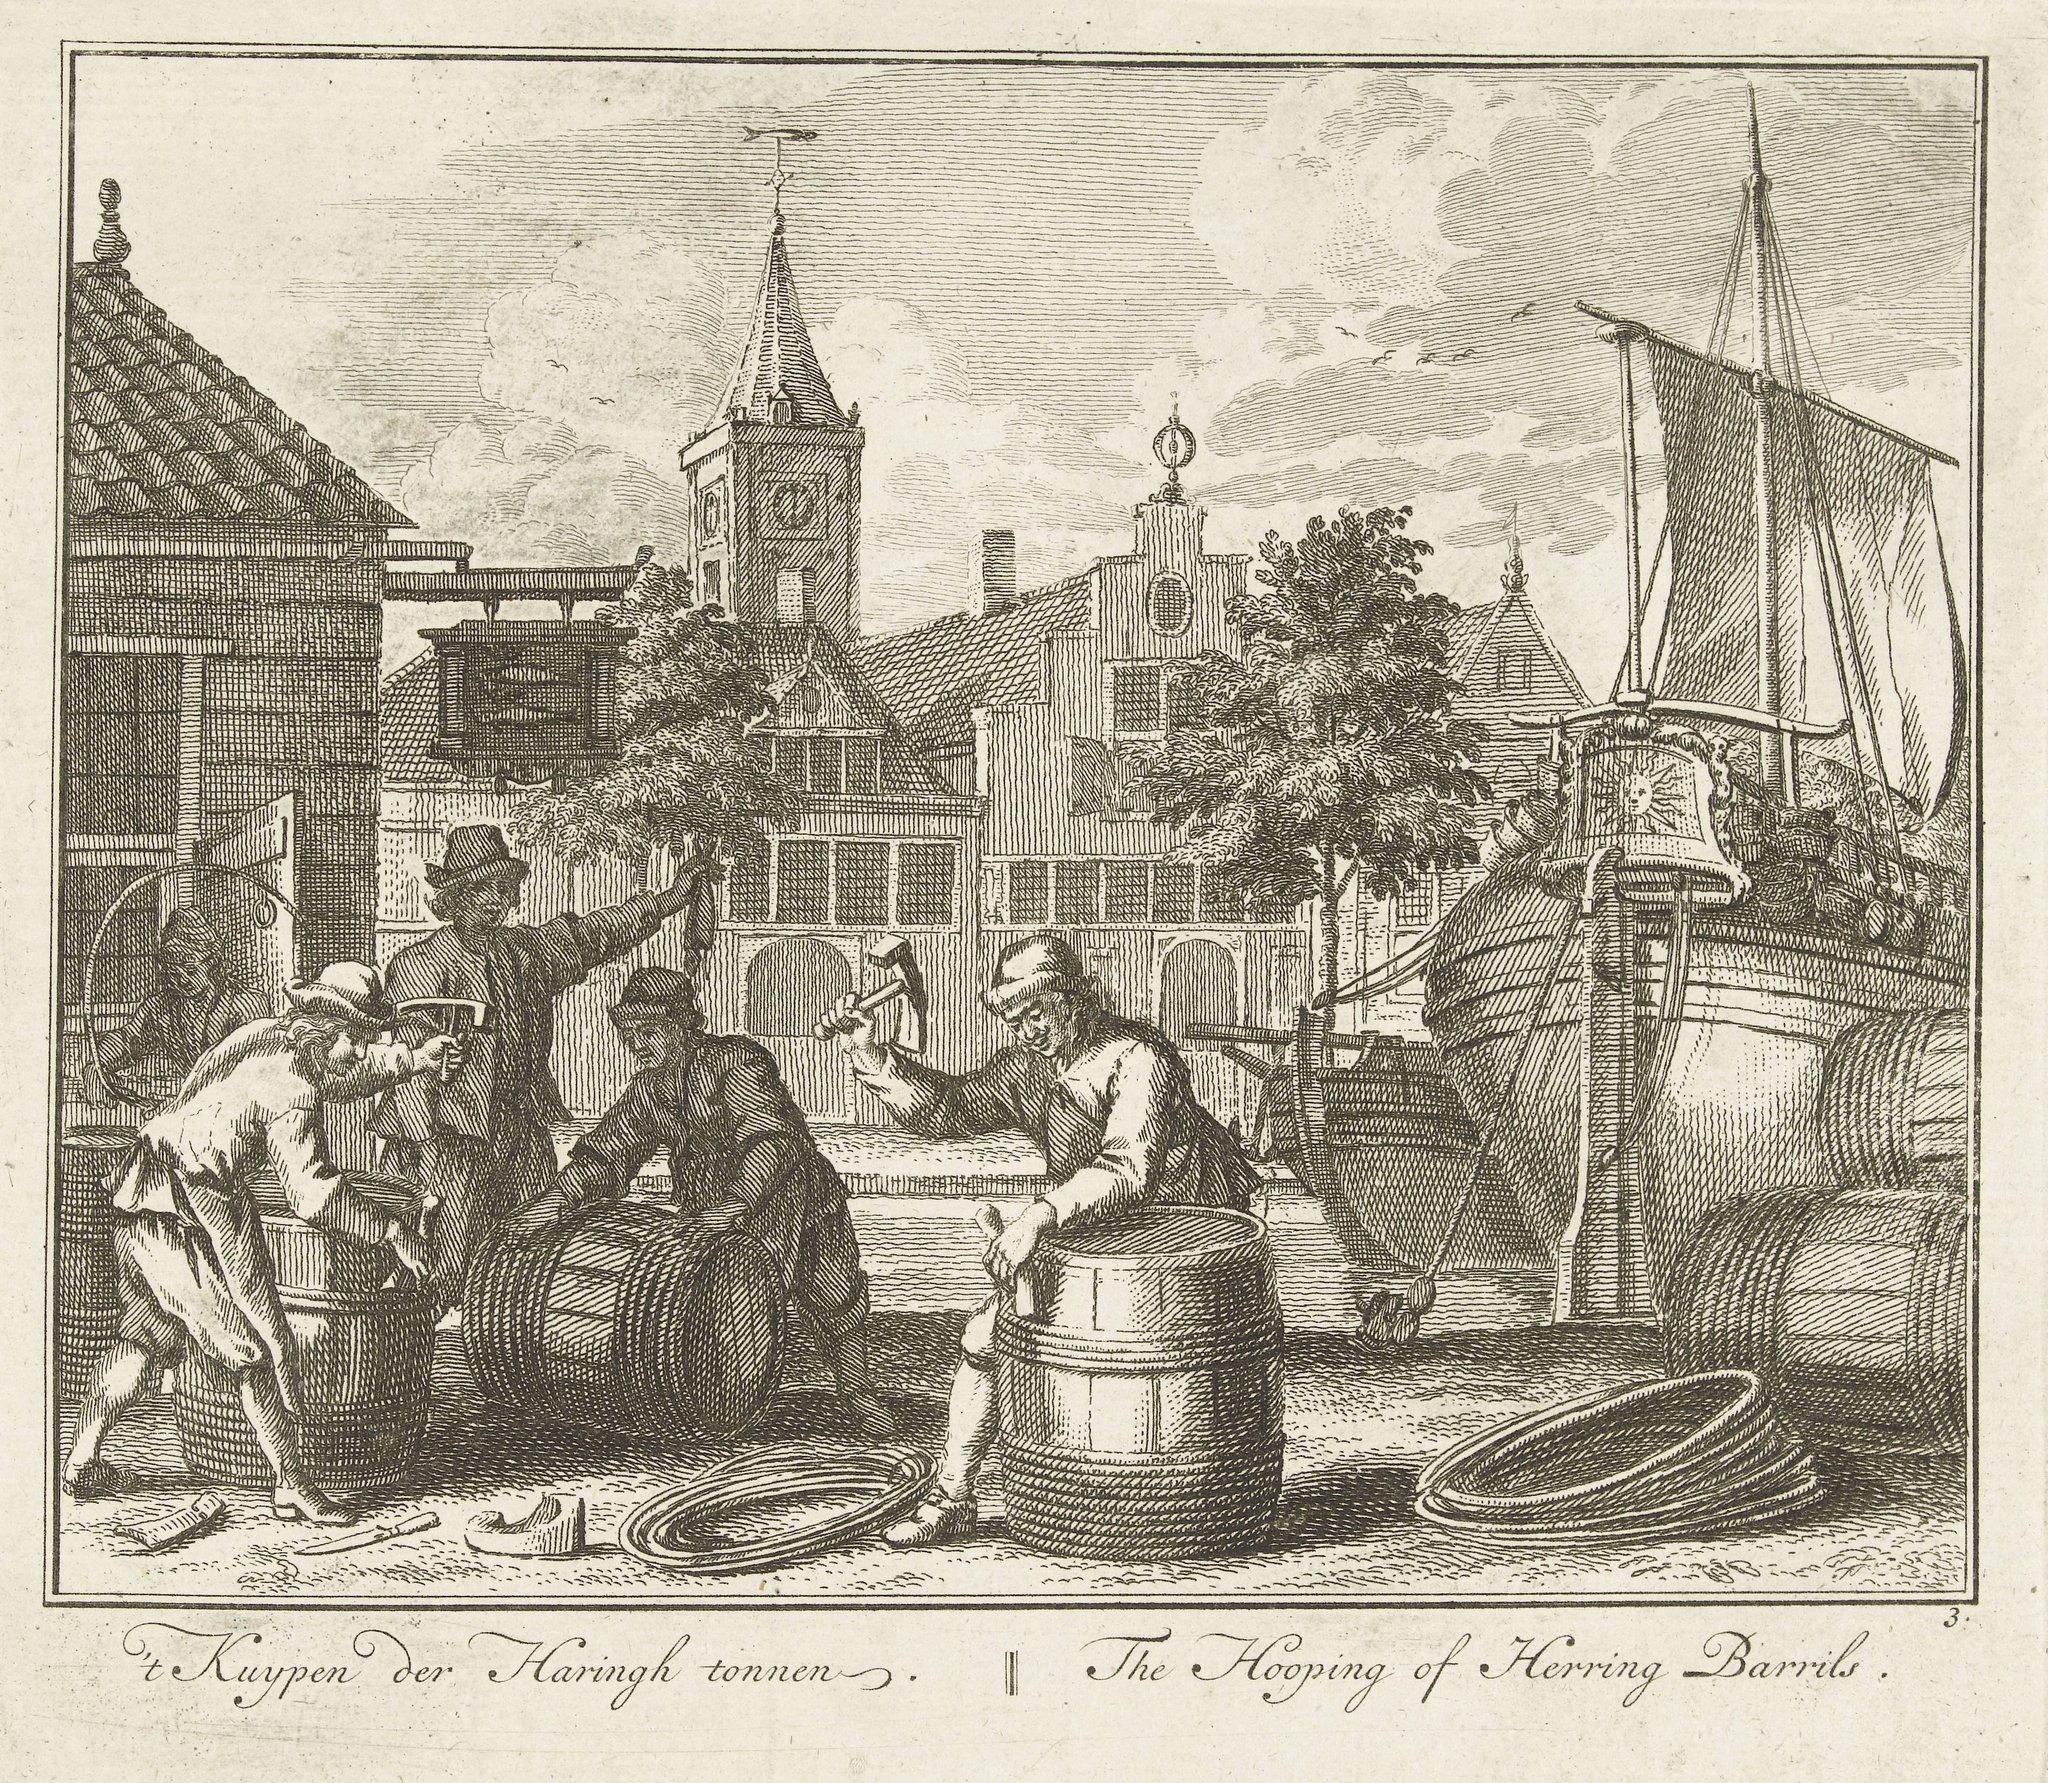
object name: print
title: Kuipen van haringtonnen, ca. 1725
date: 1720-1730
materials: paper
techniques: etching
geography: northern netherlands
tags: wooden container: barrel, cask, bucket, bony fishes: herring, handicrafts ~ wood, timber, sea and coastal fishery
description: Muller beschrijft onder FMH 3013C een ander volledig exemplaar van de serie bestaande uit 32 platen. In dit album zijn slechts 13 prenten uit de serie aanwezig (nrs 1-11, 16 en 17).